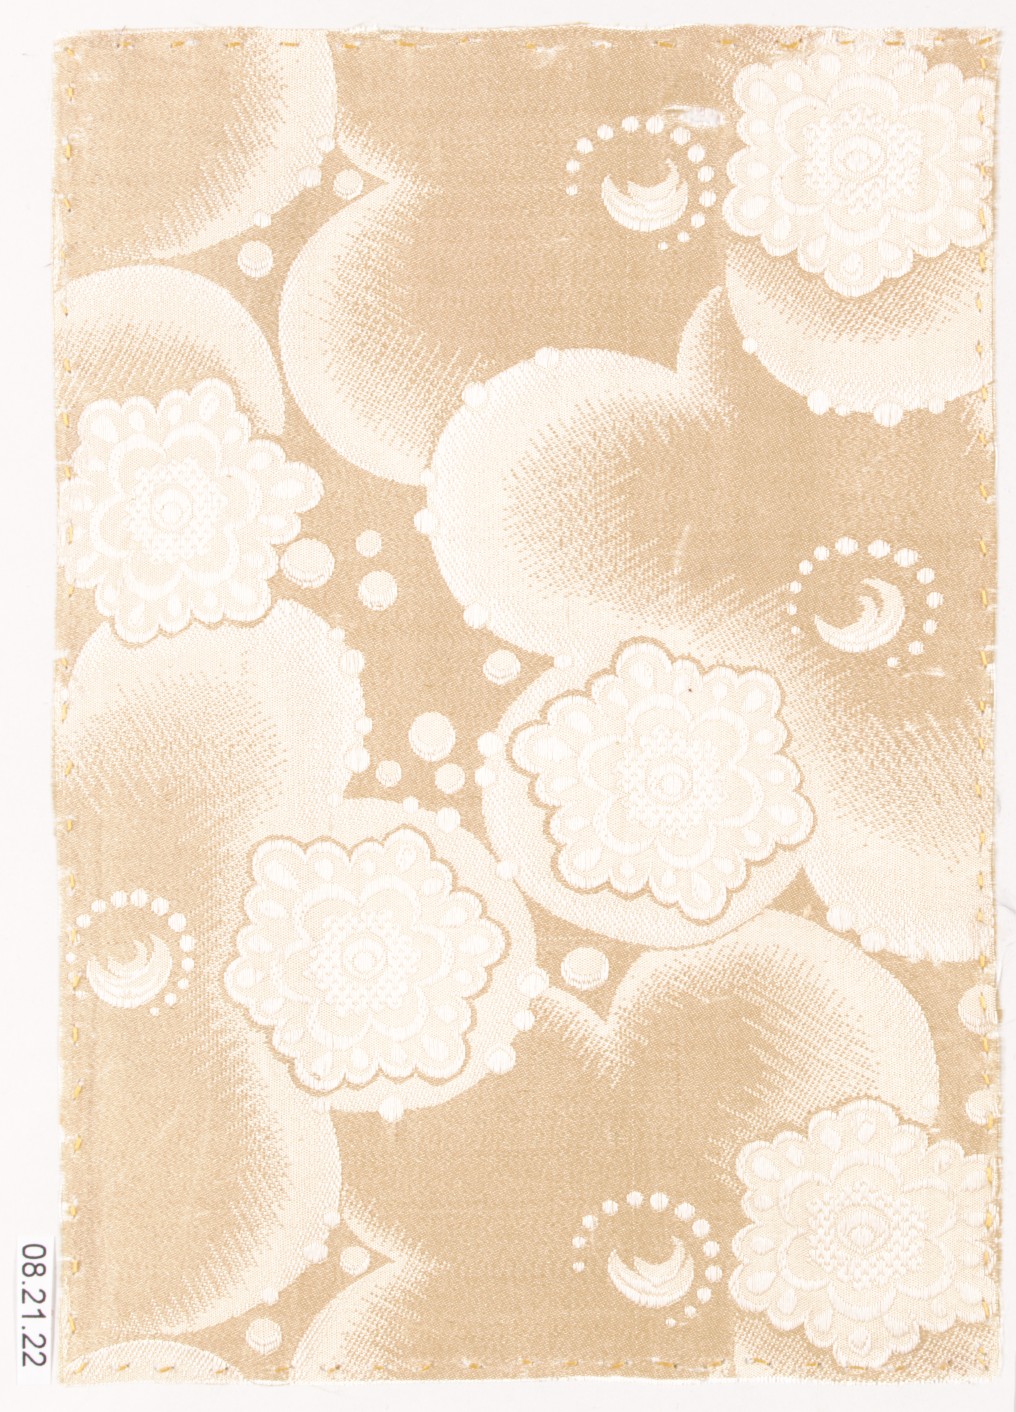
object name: textile sample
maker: Anonymous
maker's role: designer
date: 1900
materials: silk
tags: flowers